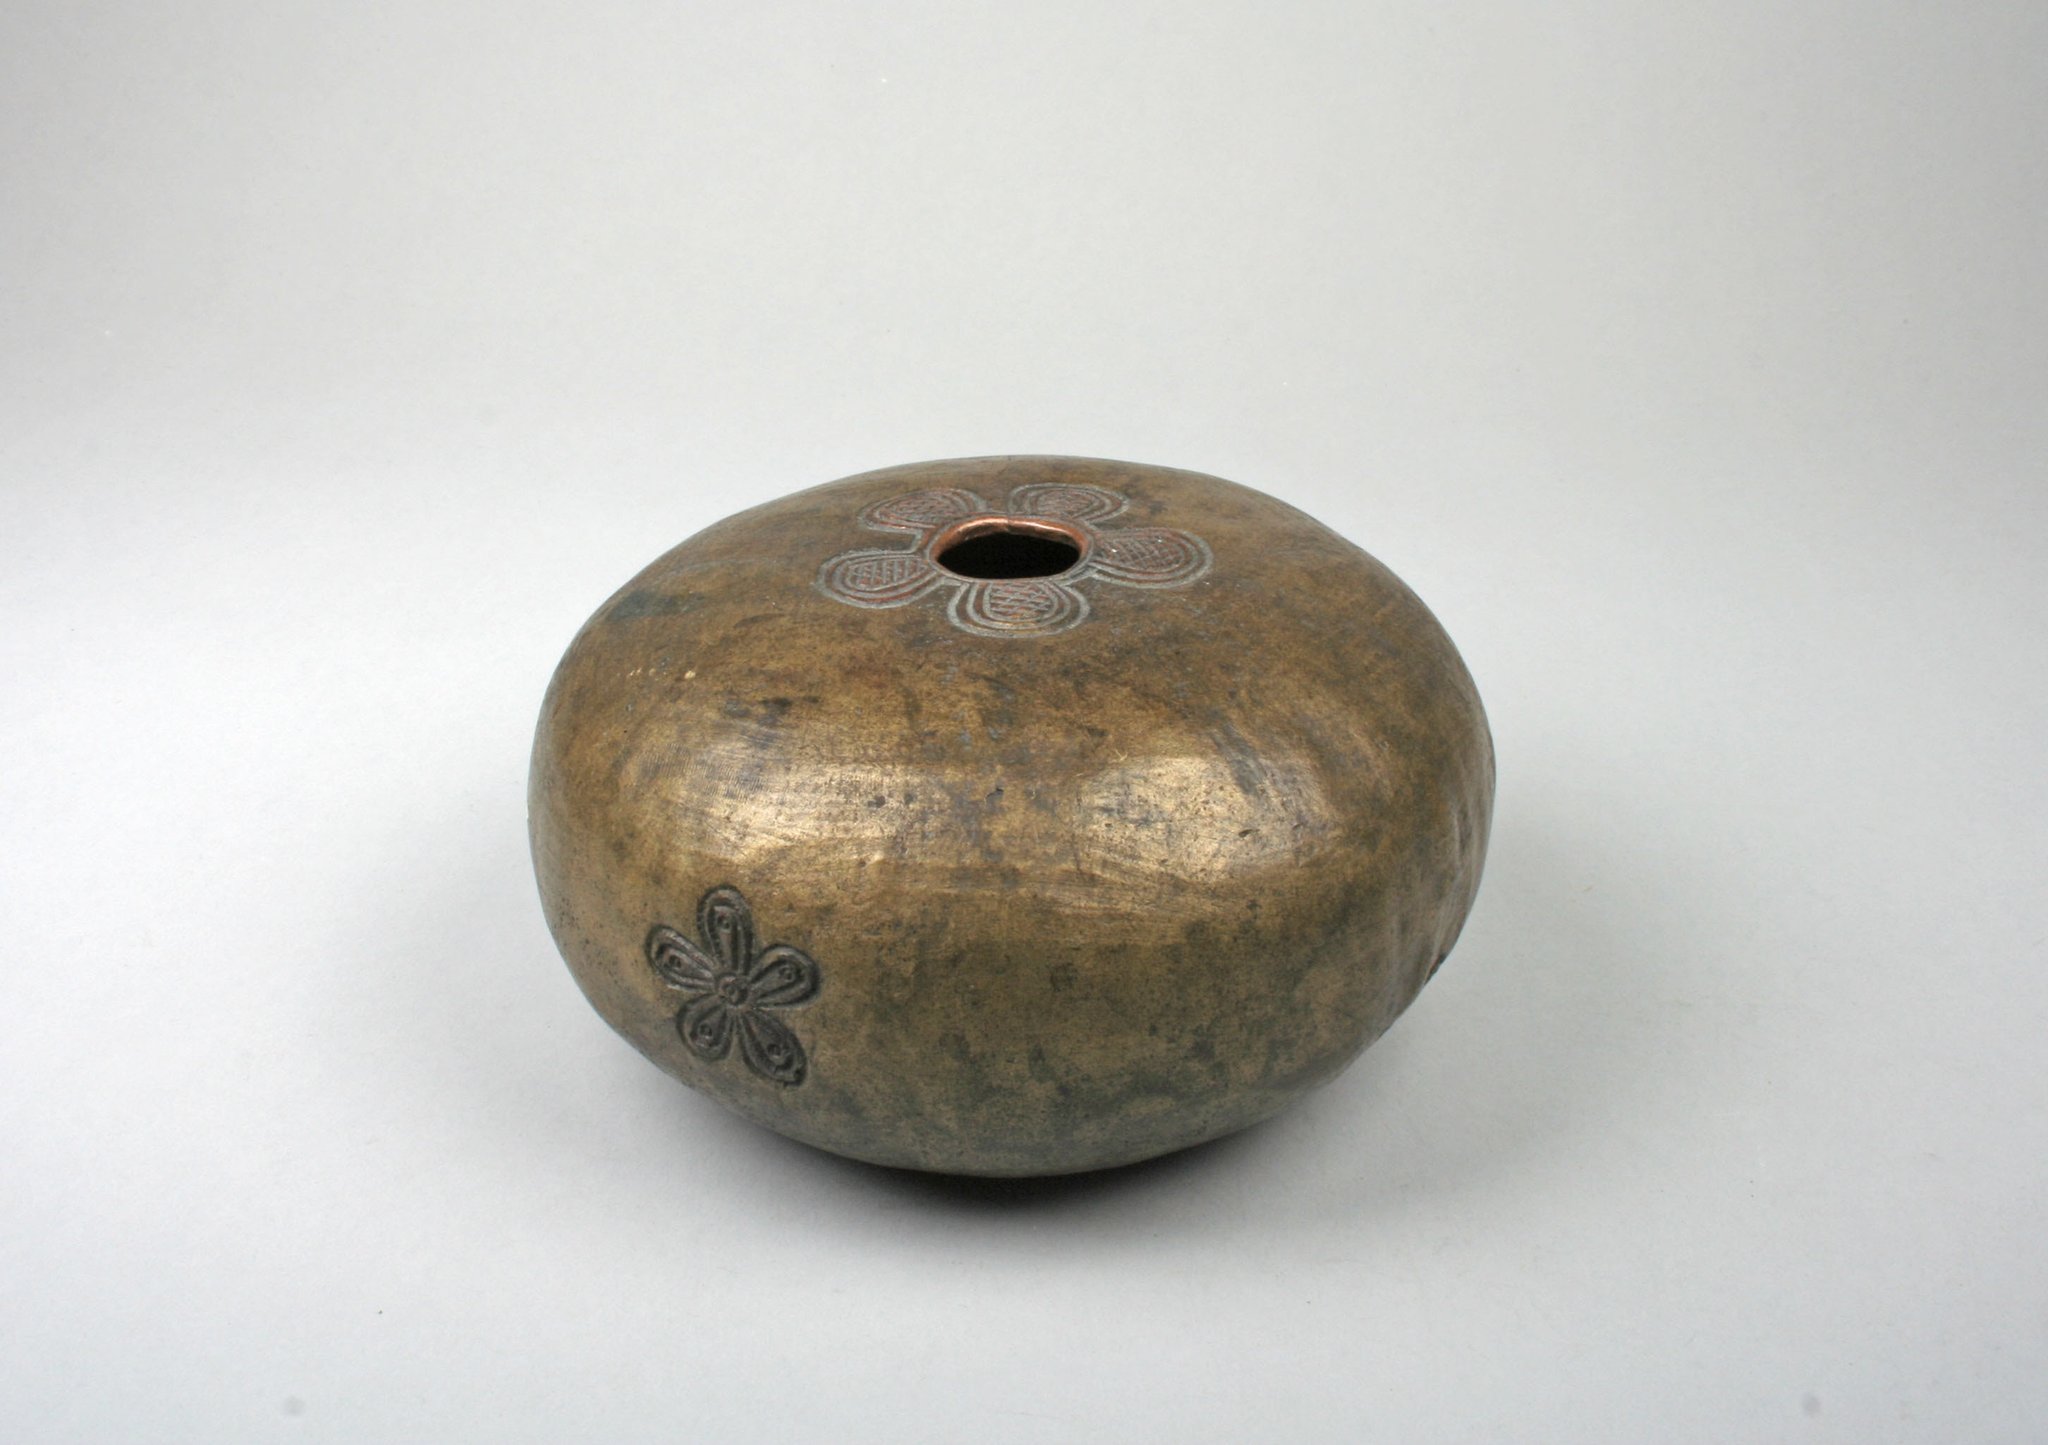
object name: vessel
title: Vessel (?)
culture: edo period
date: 1501-1900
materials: brass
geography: nigeria